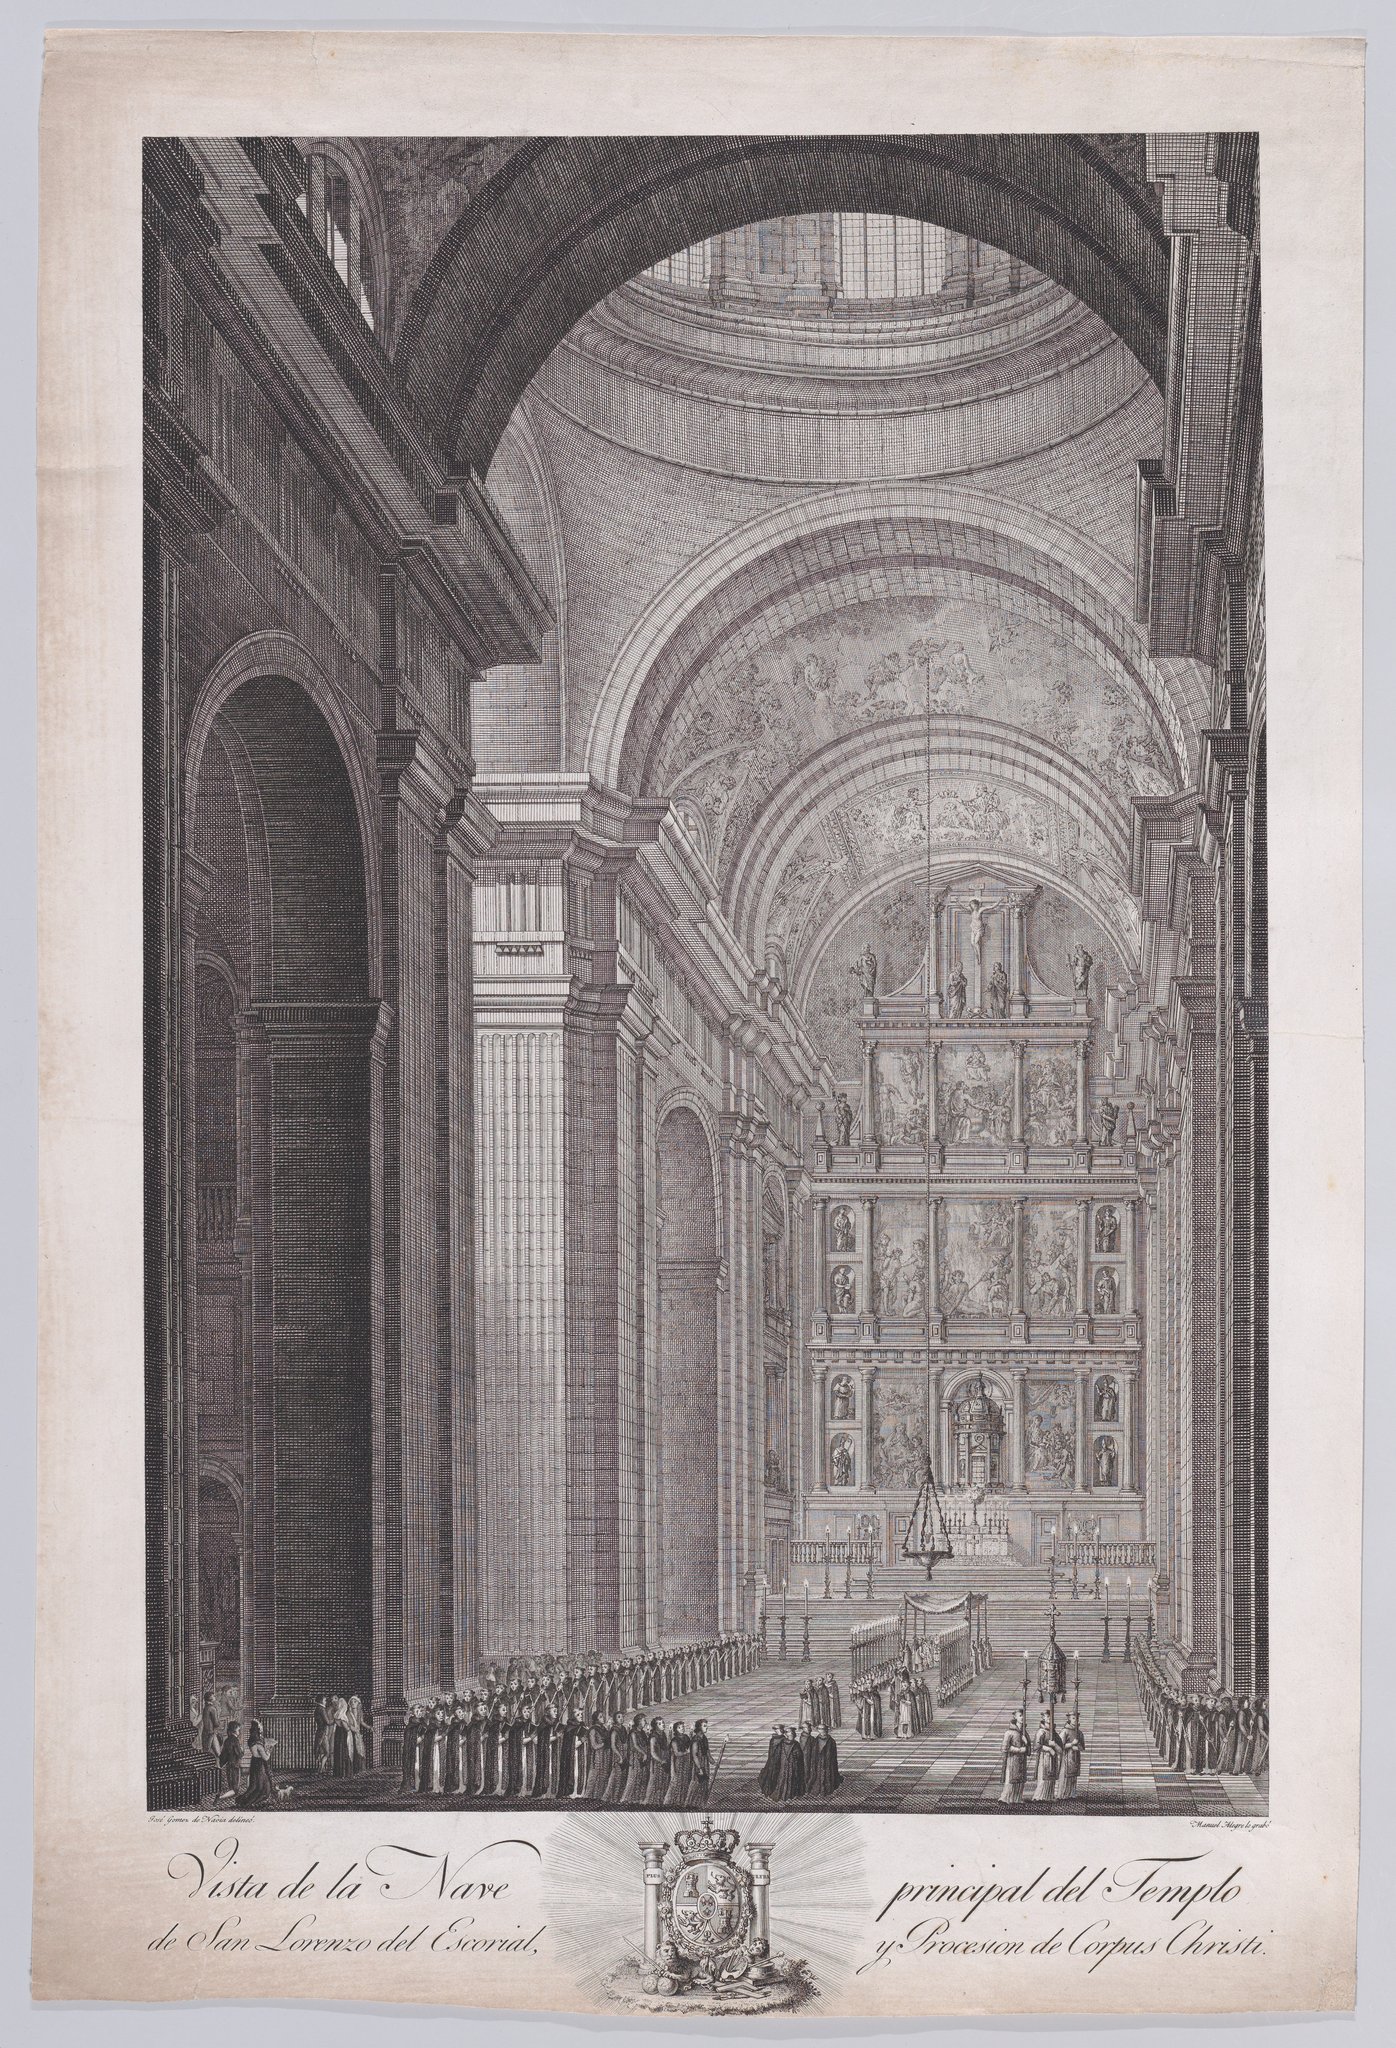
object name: print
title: The procession of Corpus Christi in the nave of the Church of the monastery of El Escorial, from "Views of El Escorial"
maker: manuel alegre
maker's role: artist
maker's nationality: spanish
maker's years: 1768-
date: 1790-1800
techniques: engraving, etching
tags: interiors,churches,processions